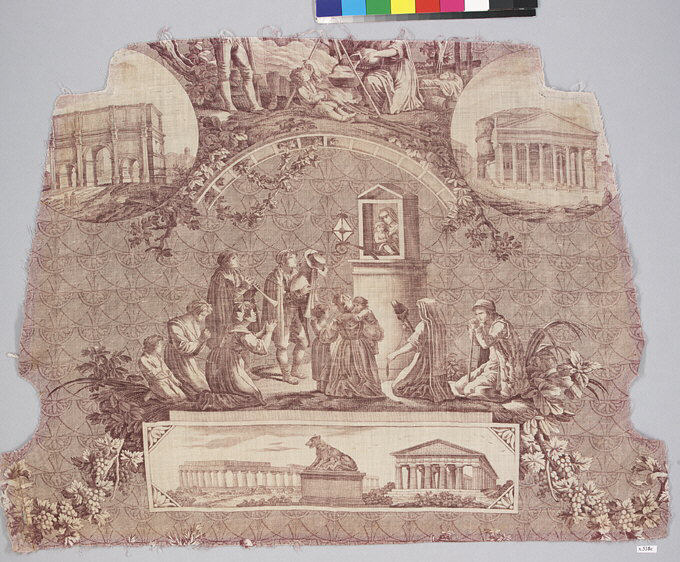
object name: piece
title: Scènes romaines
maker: bartolomeo penelli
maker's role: designer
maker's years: 1750-1850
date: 1811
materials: cotton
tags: infants,men,women